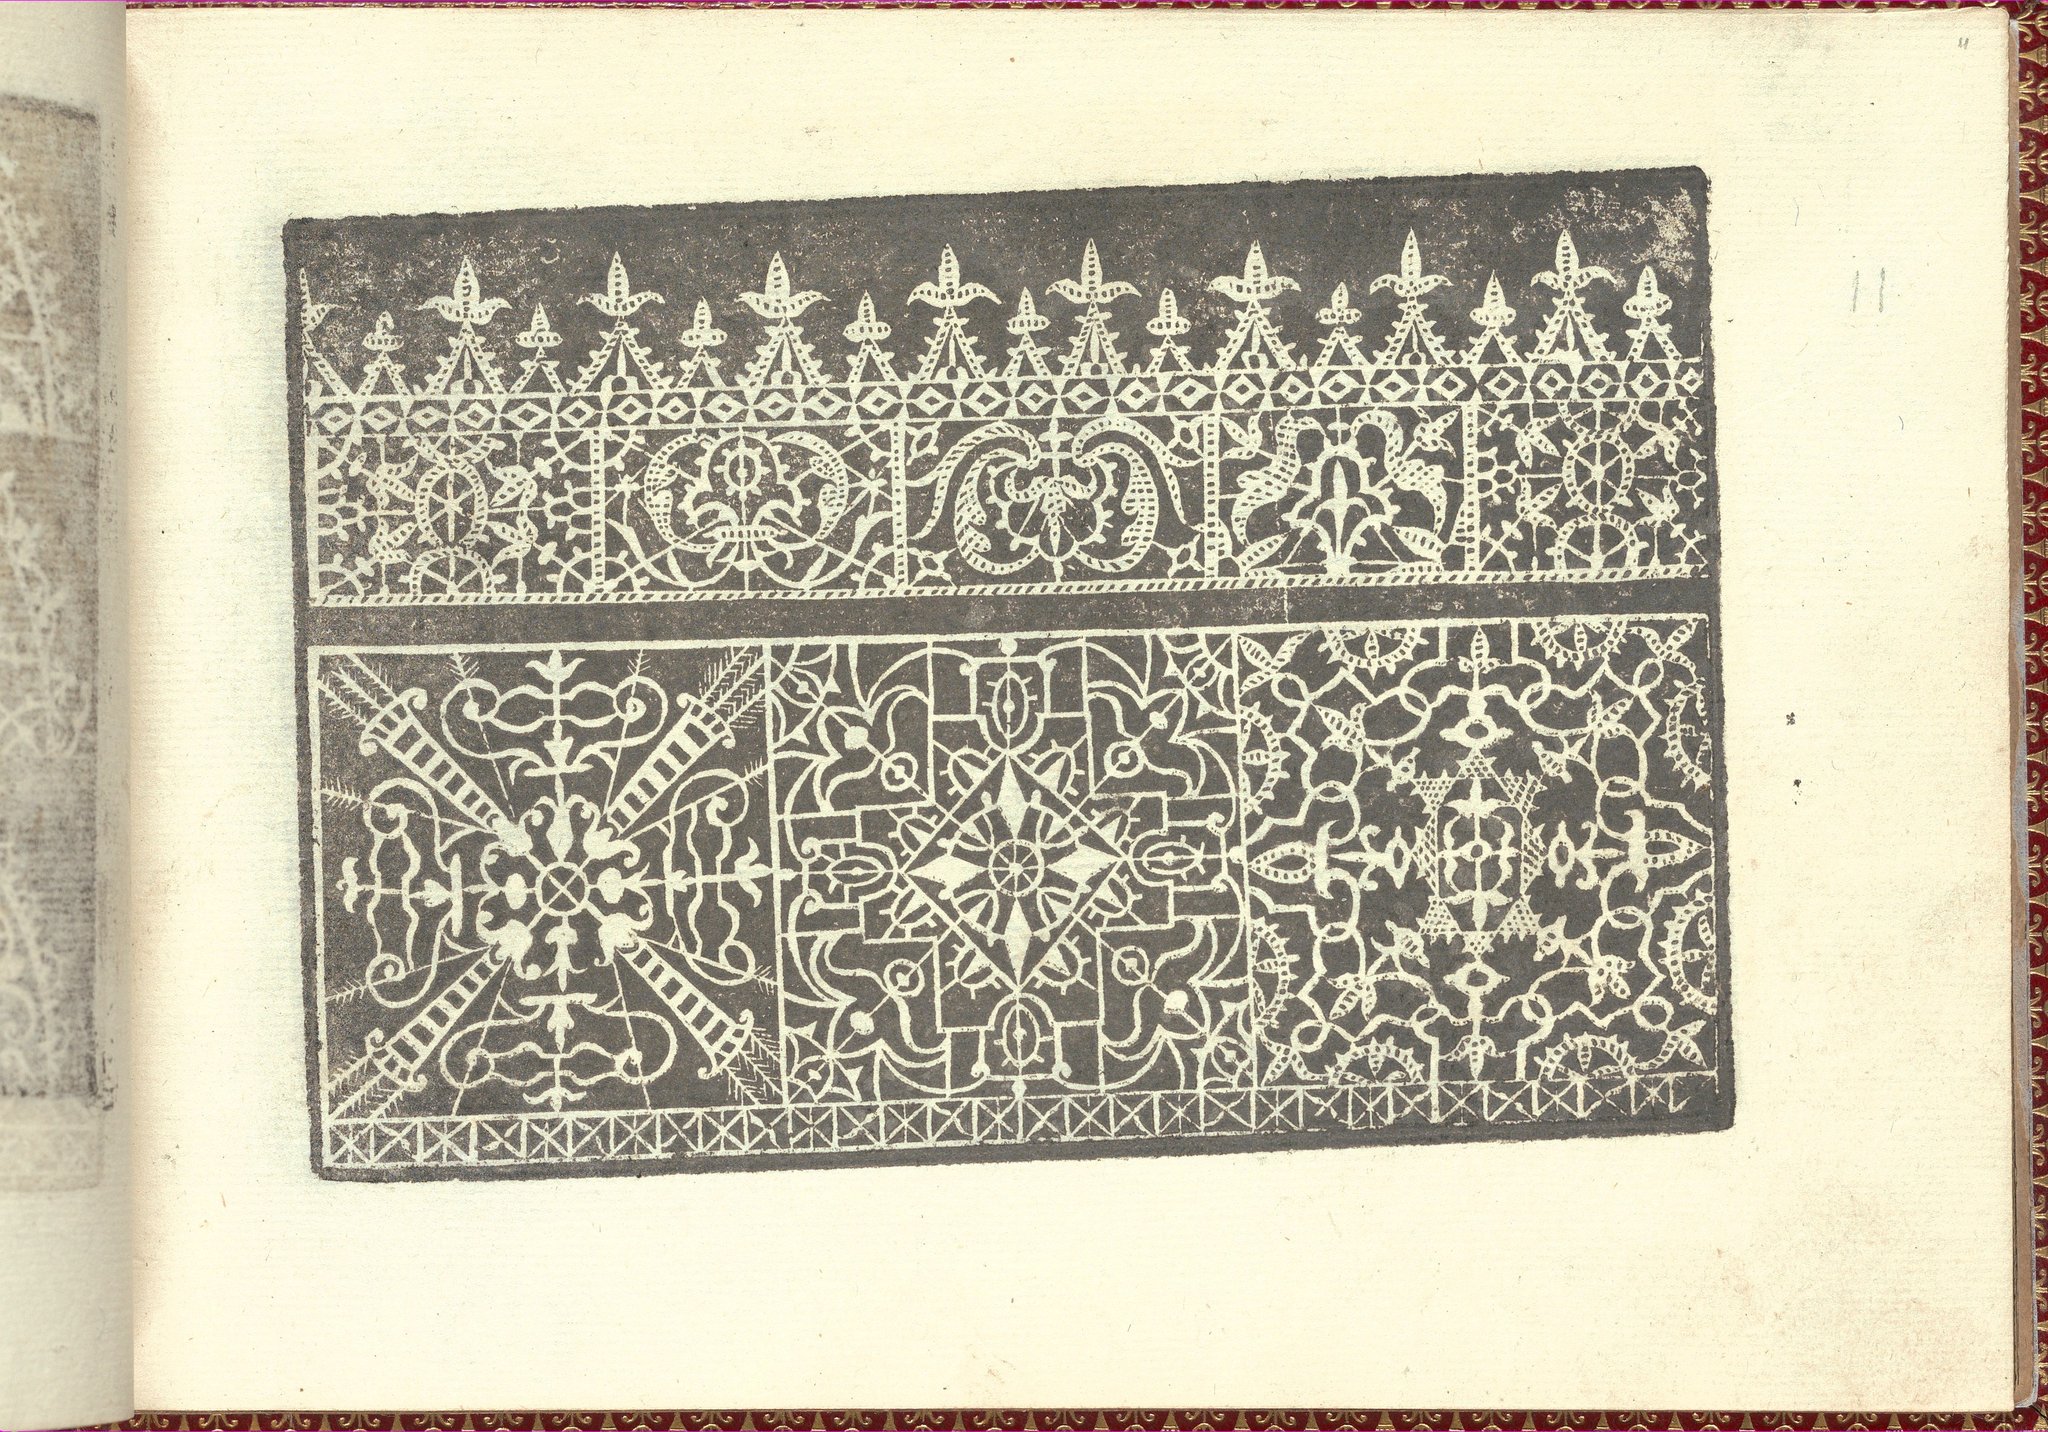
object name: book print ornament architecture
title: Corona delle Nobili et Virtuose Donne: Libro I-IV, page 11 (recto)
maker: cesare vecellio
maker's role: publisher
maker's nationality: italian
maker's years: 1521-1601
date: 1601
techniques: woodcut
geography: italy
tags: ornament